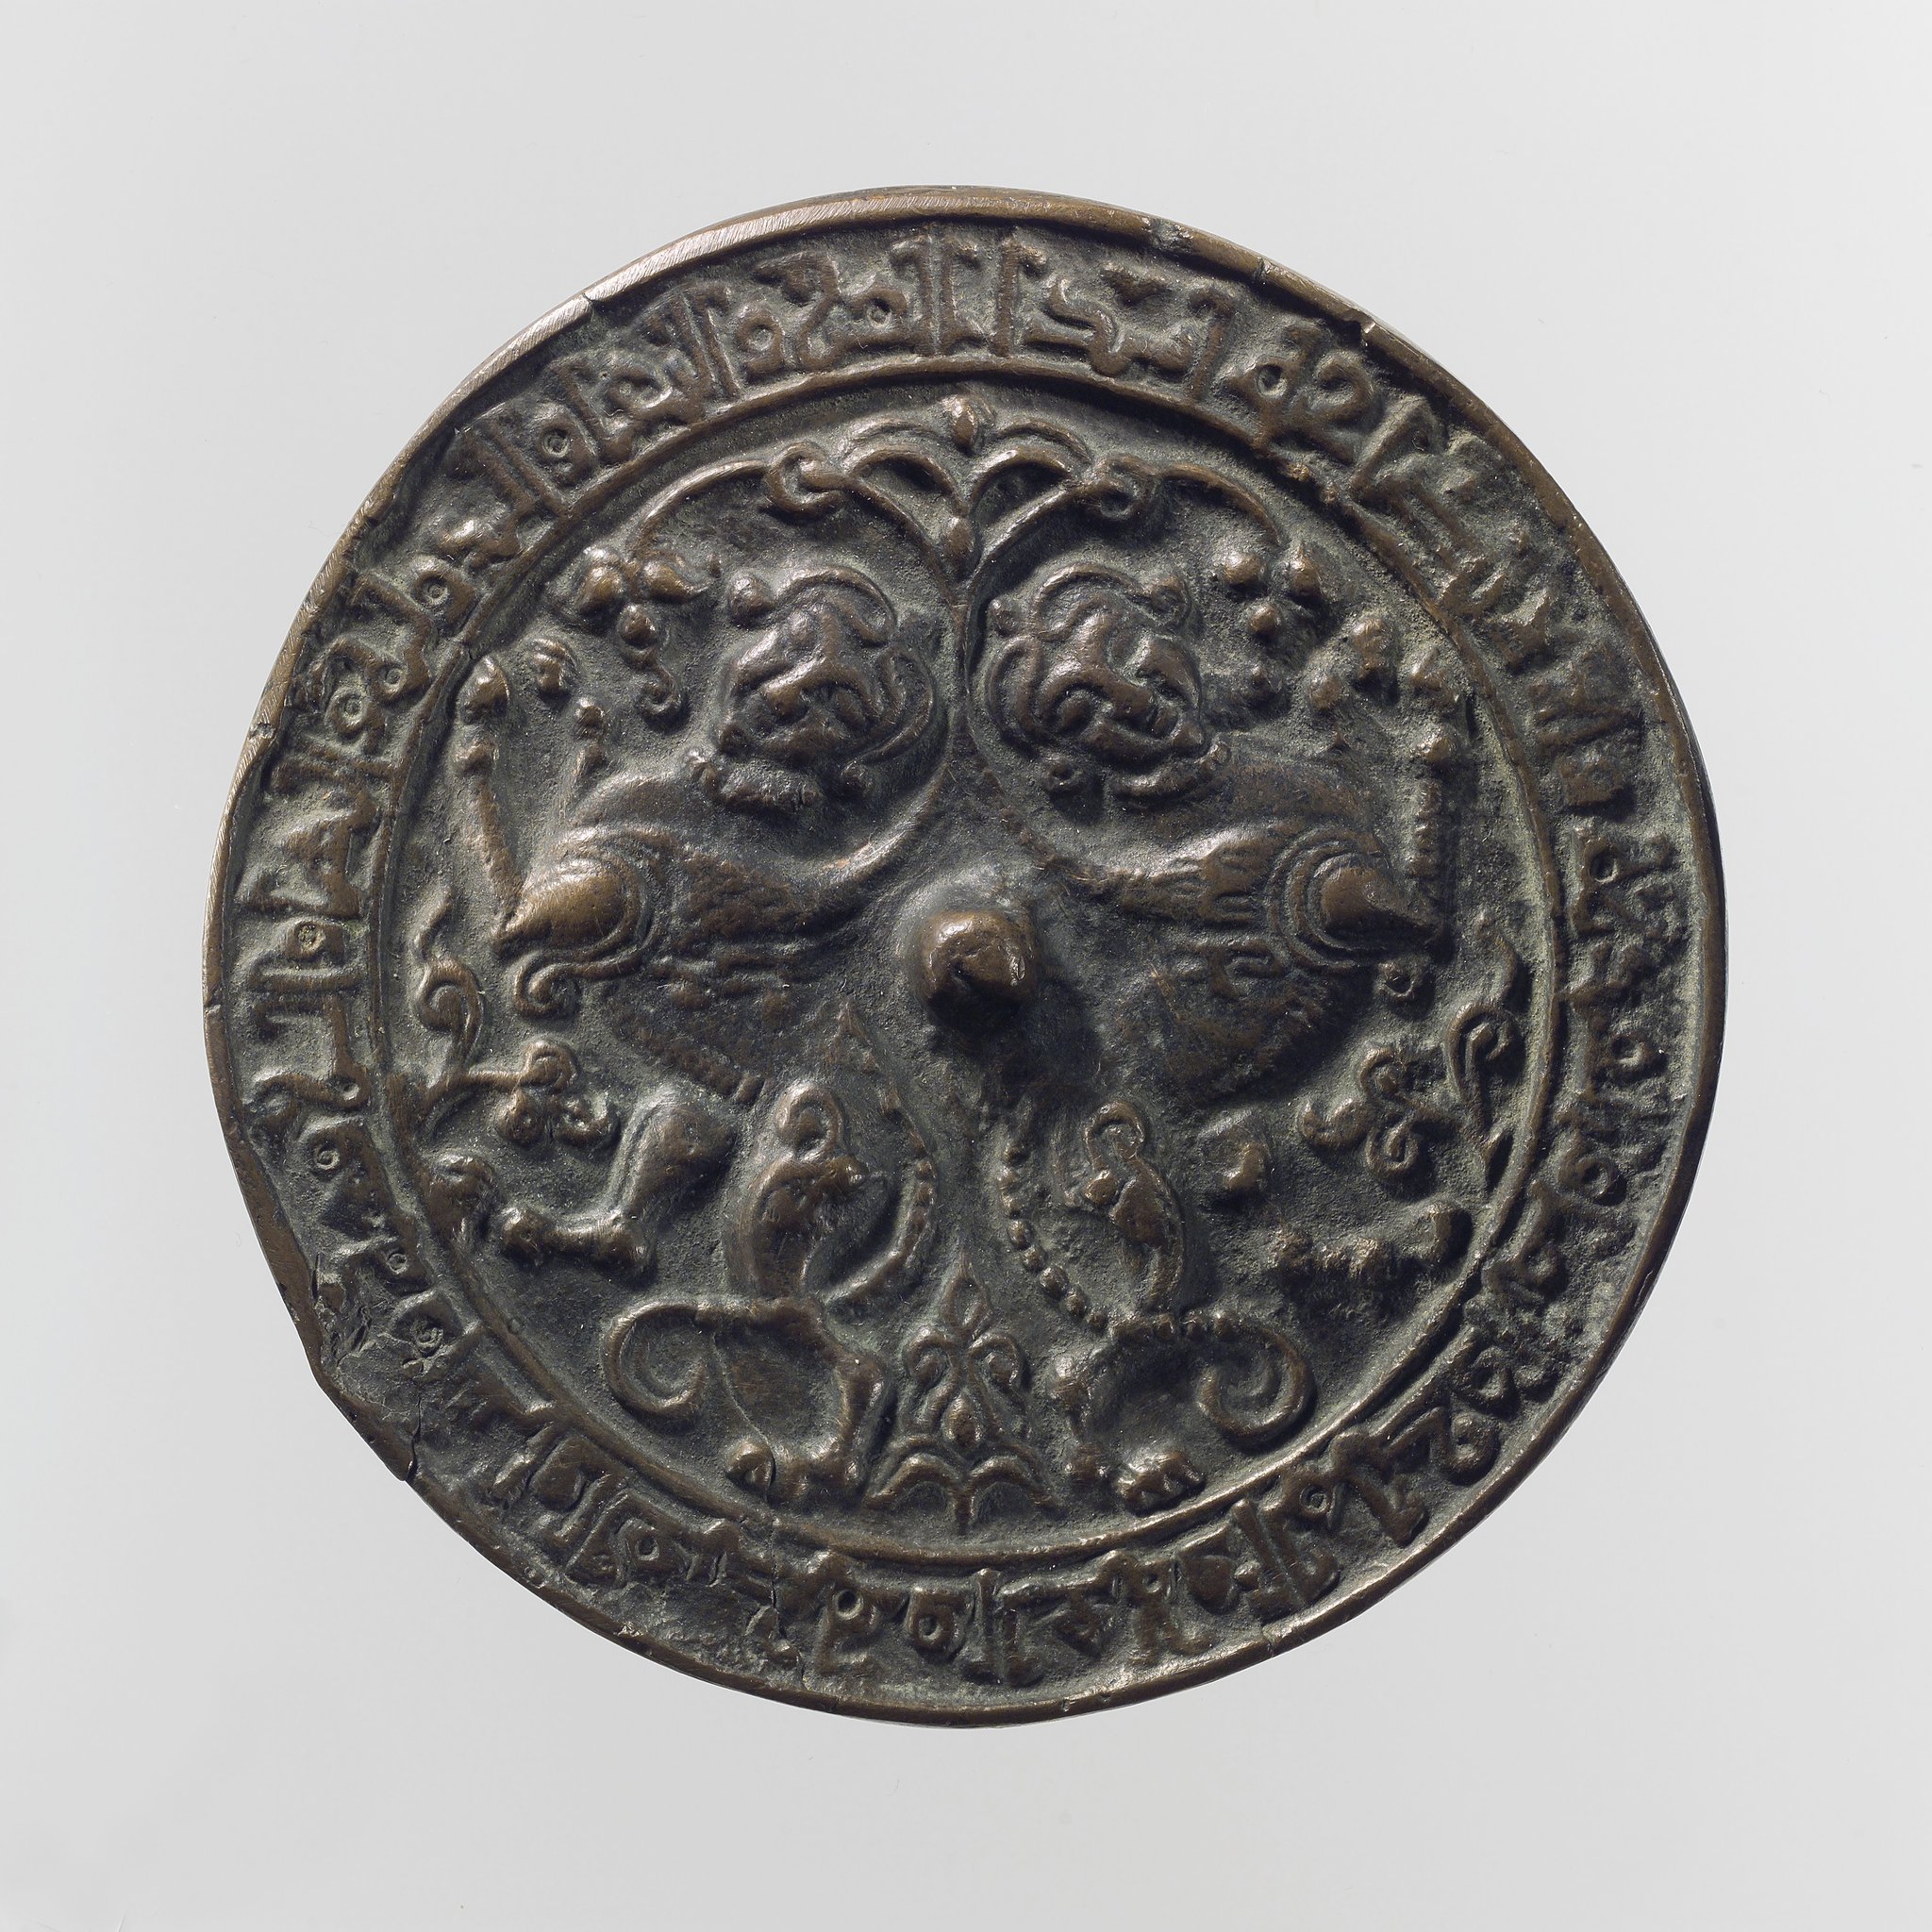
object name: mirror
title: Mirror with a Pair of Addorsed Sphinxes with Scorpion Tails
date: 1101-1300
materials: bronze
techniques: casting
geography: iran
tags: sphinx